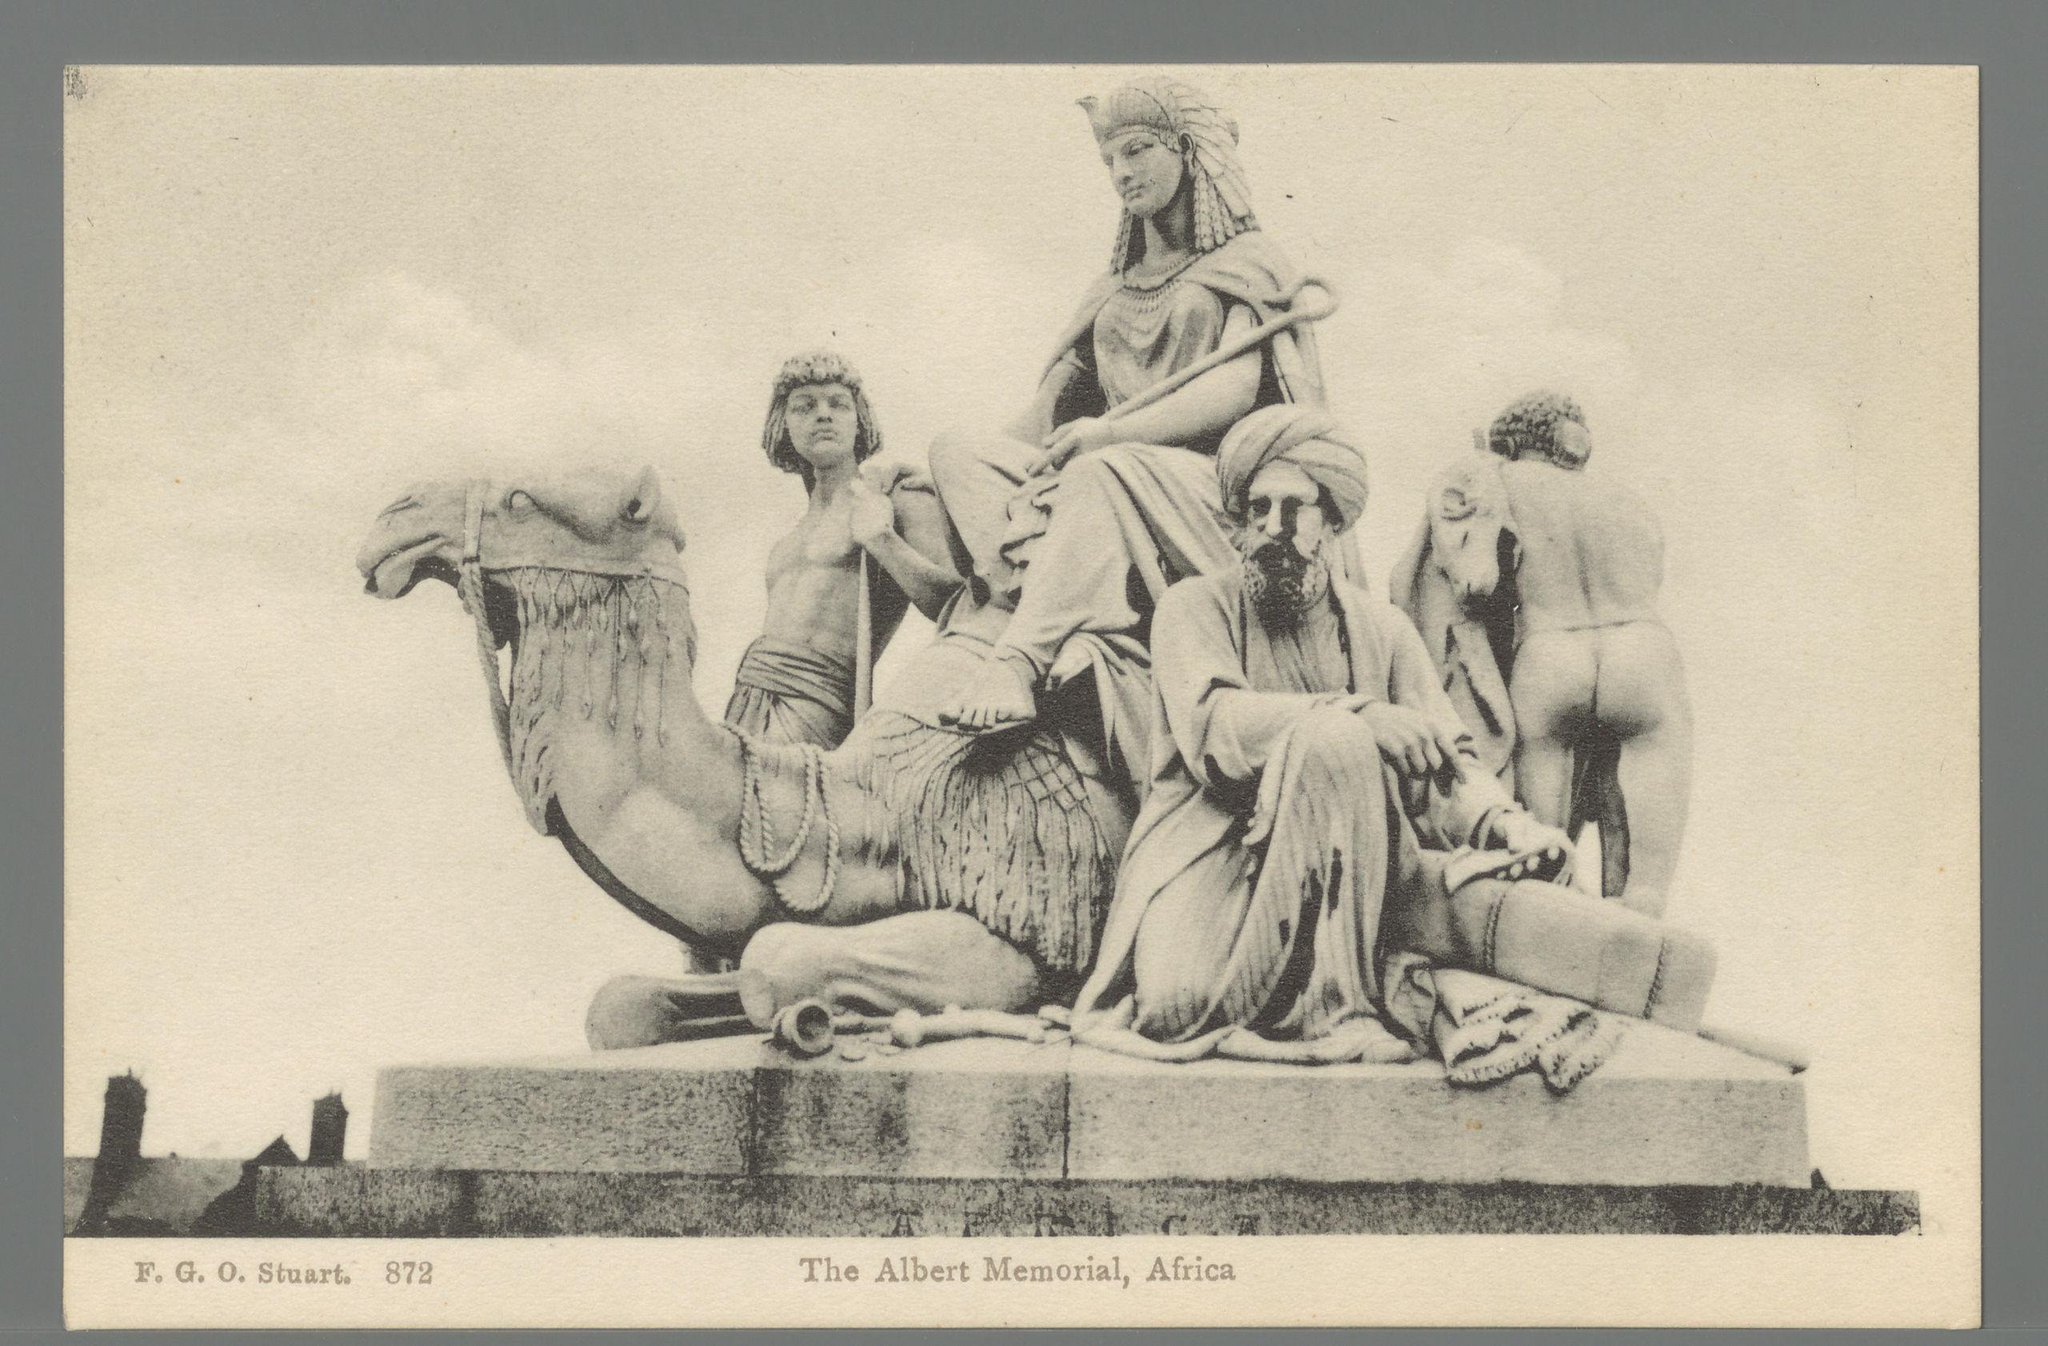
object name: photomechanical print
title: The Albert Memorial, Africa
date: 1902-1930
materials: cardboard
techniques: photograph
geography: london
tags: hoofed animals: camel, africa represented allegorically; 'africa' (ripa), monument, statue